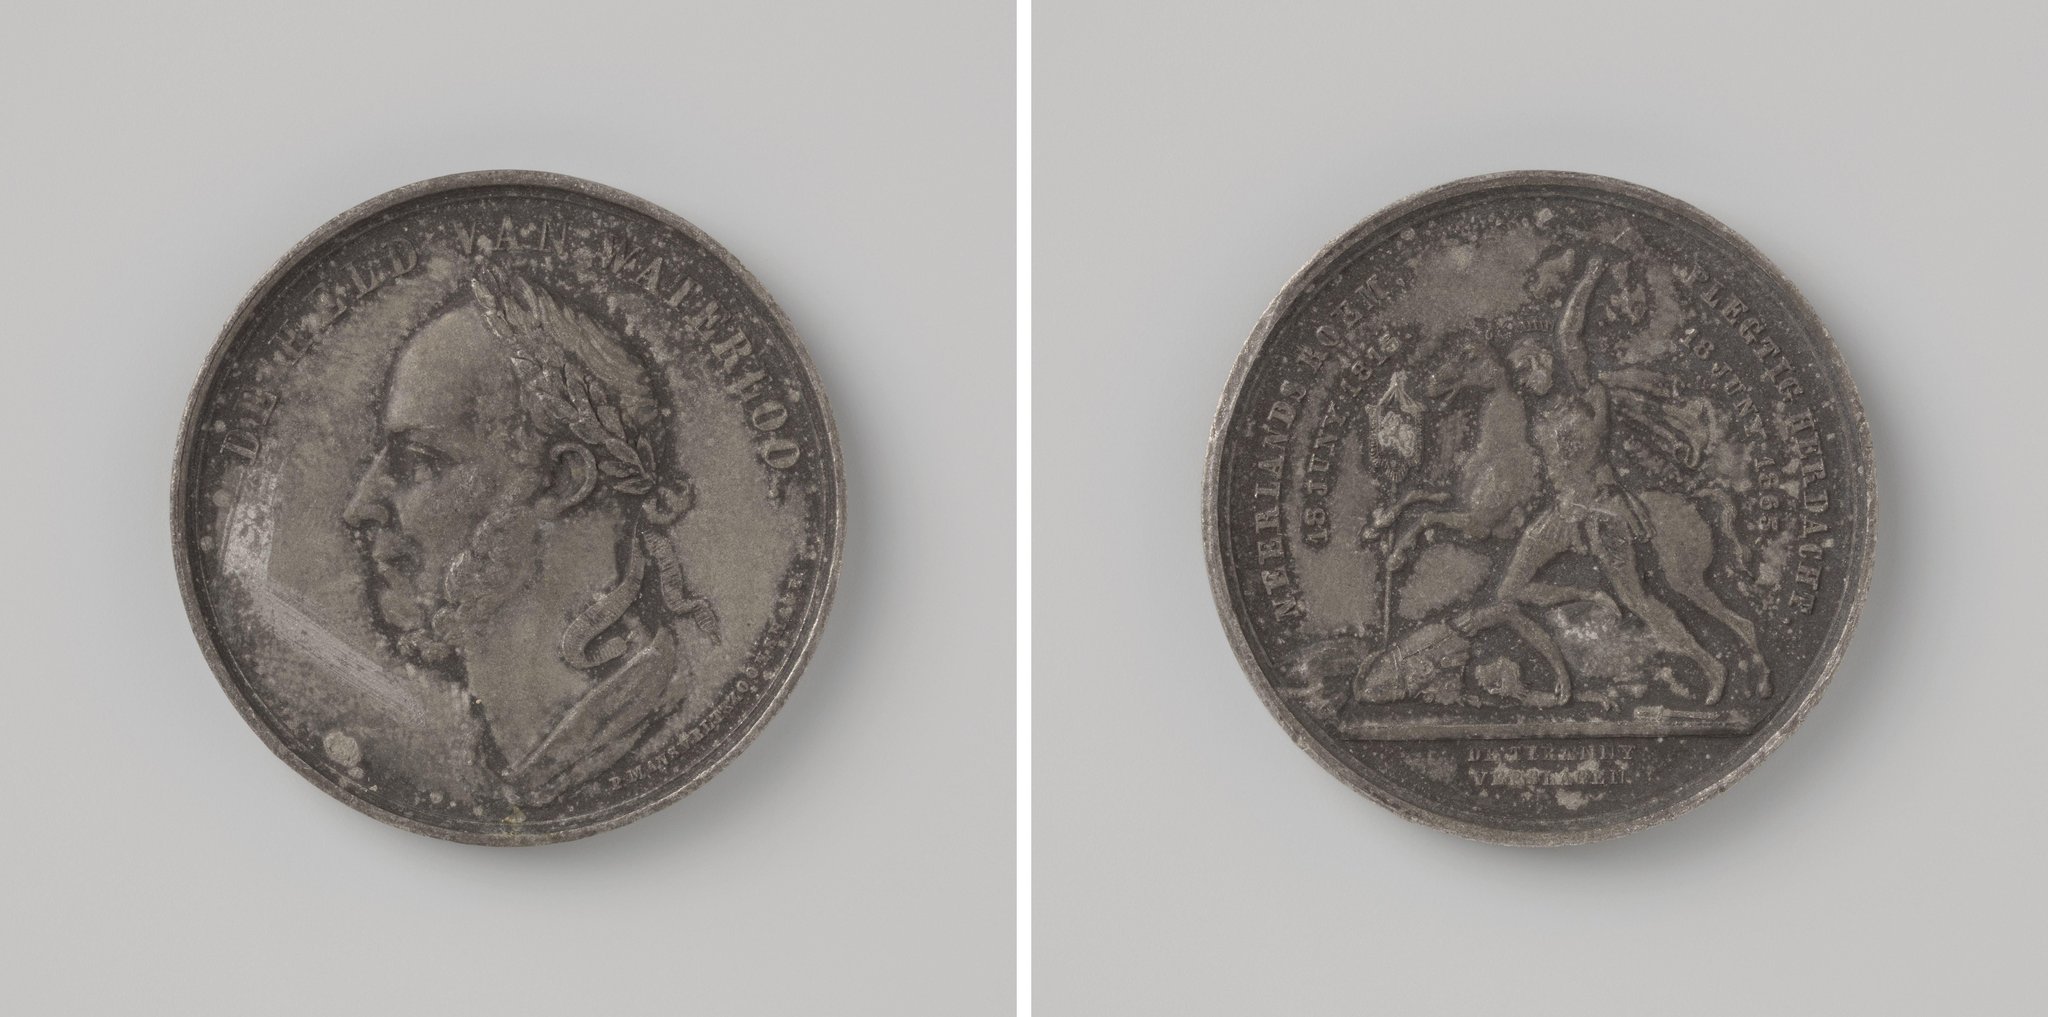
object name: history medal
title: Vijftigjarige herdenking van de Slag bij Waterloo 1865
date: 1865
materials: tin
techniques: striking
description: Tinnen penning, op de voorzijde het gelauwerde portret van Koning Willem II naar links, met omschrift, op de keerzijde een man die een liggende vijand met een steen gaat verpletteren, daarachter een paard en een Nederlands vaandel, met omschrift en afsnedetekst.